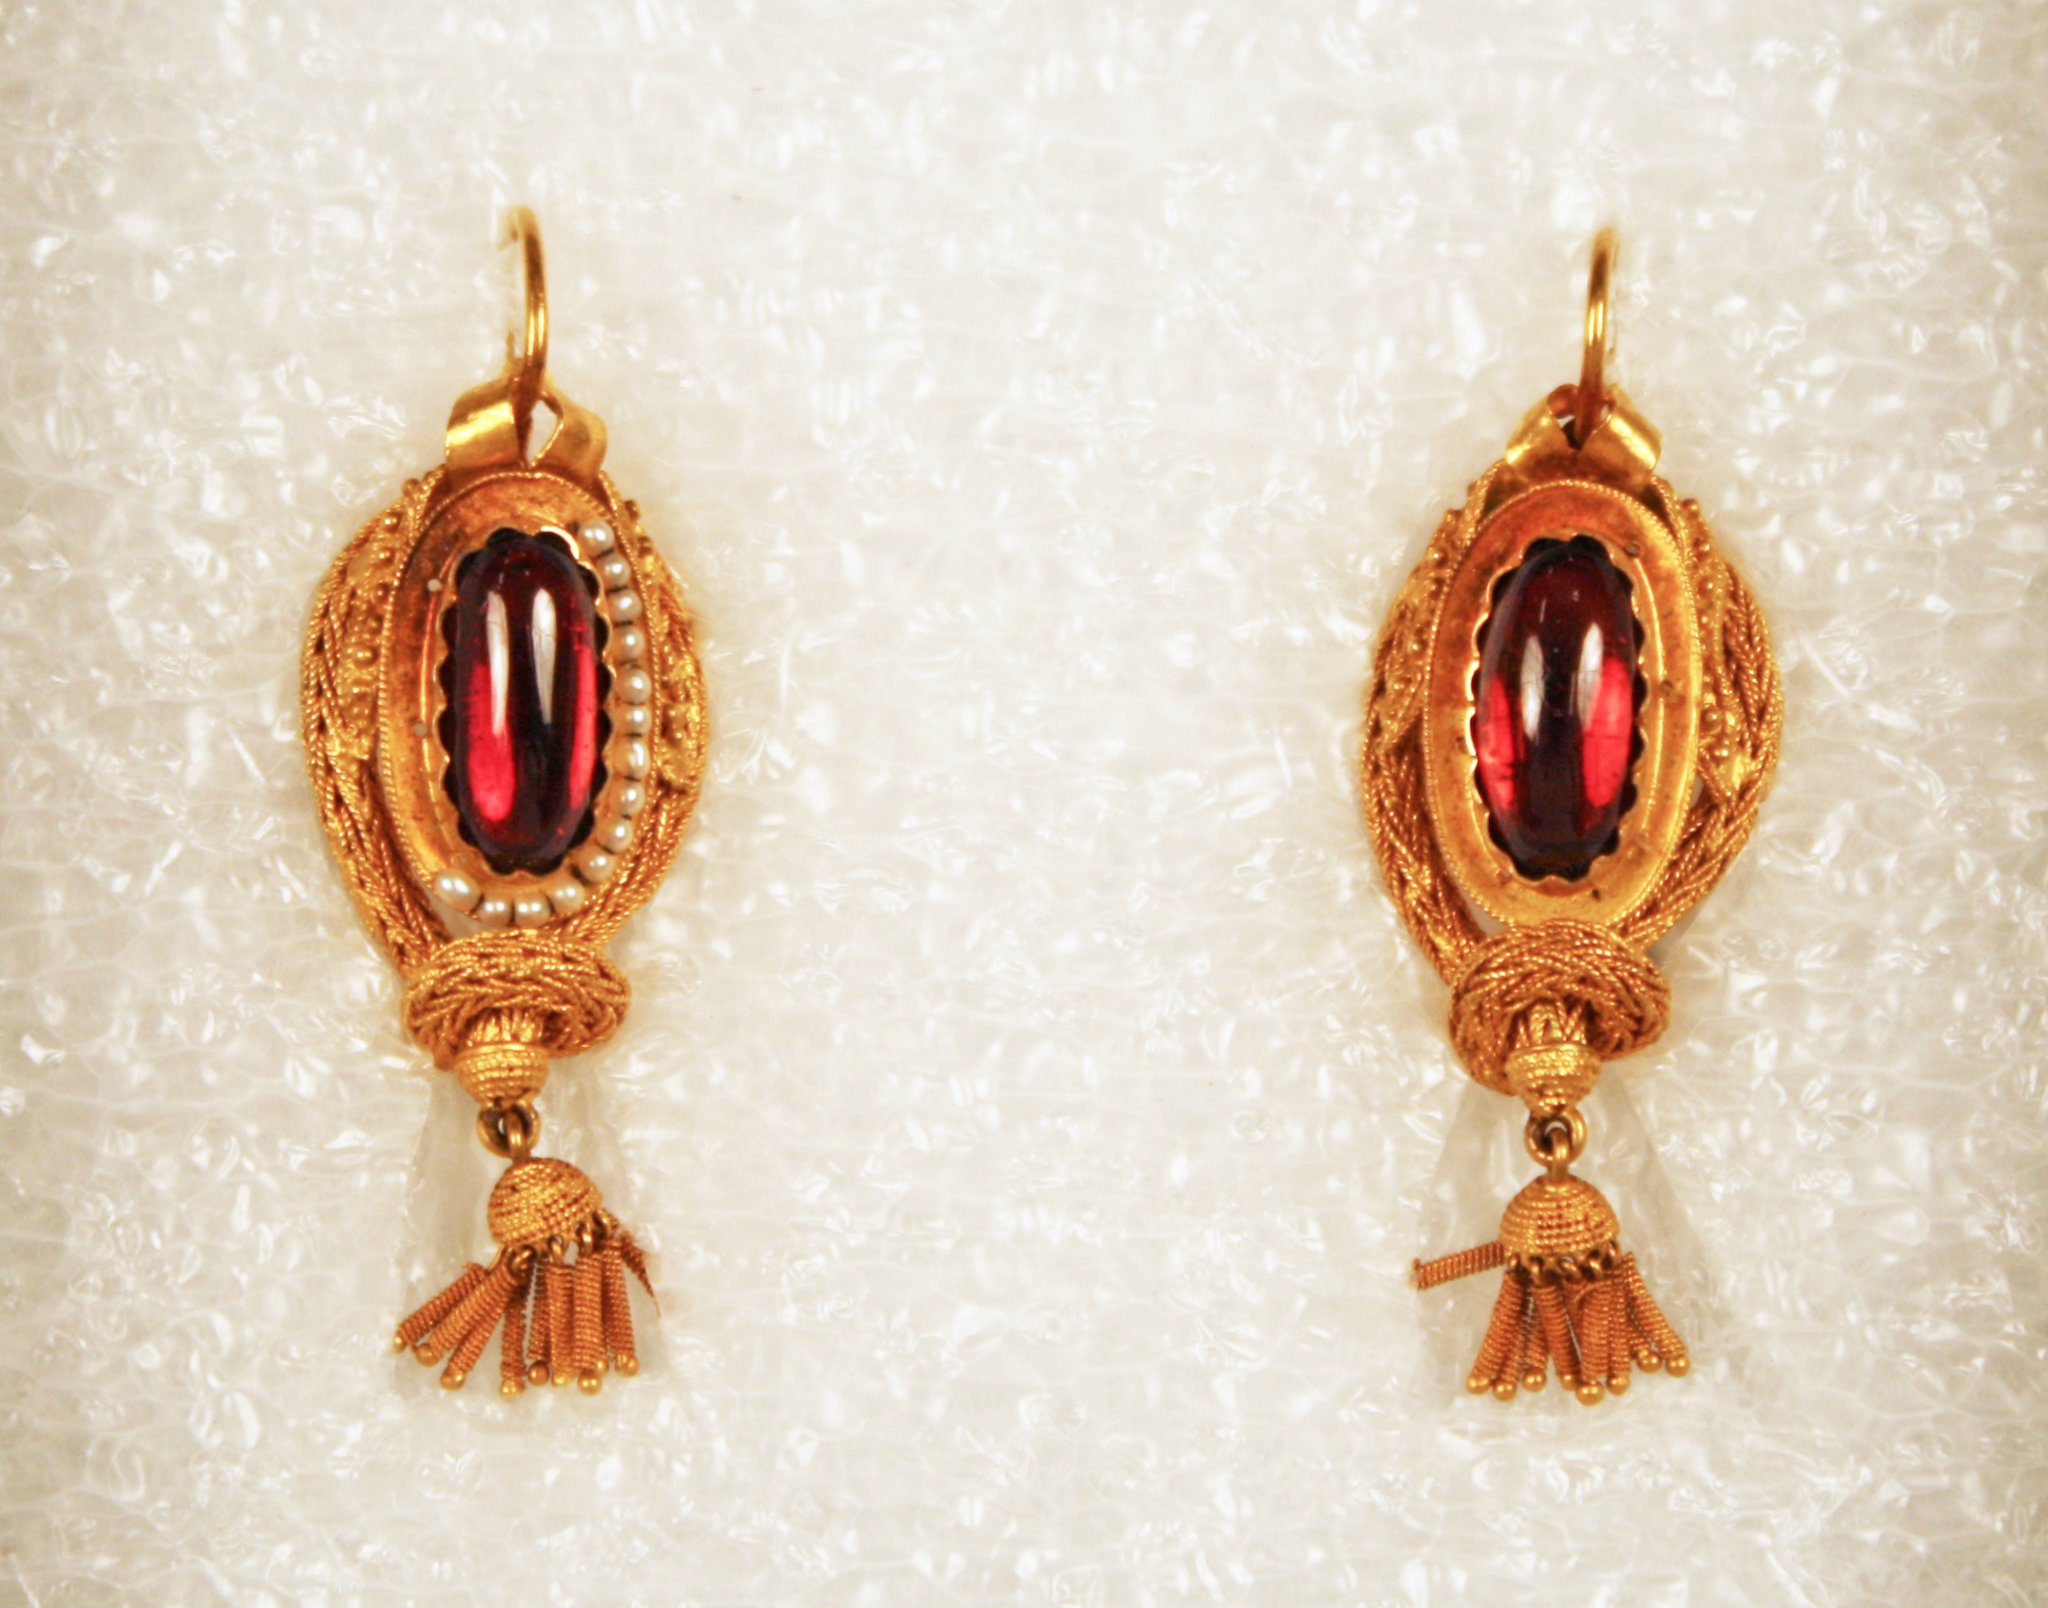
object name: earring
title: Earrings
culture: american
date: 1850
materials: gemstone, gold, pearl